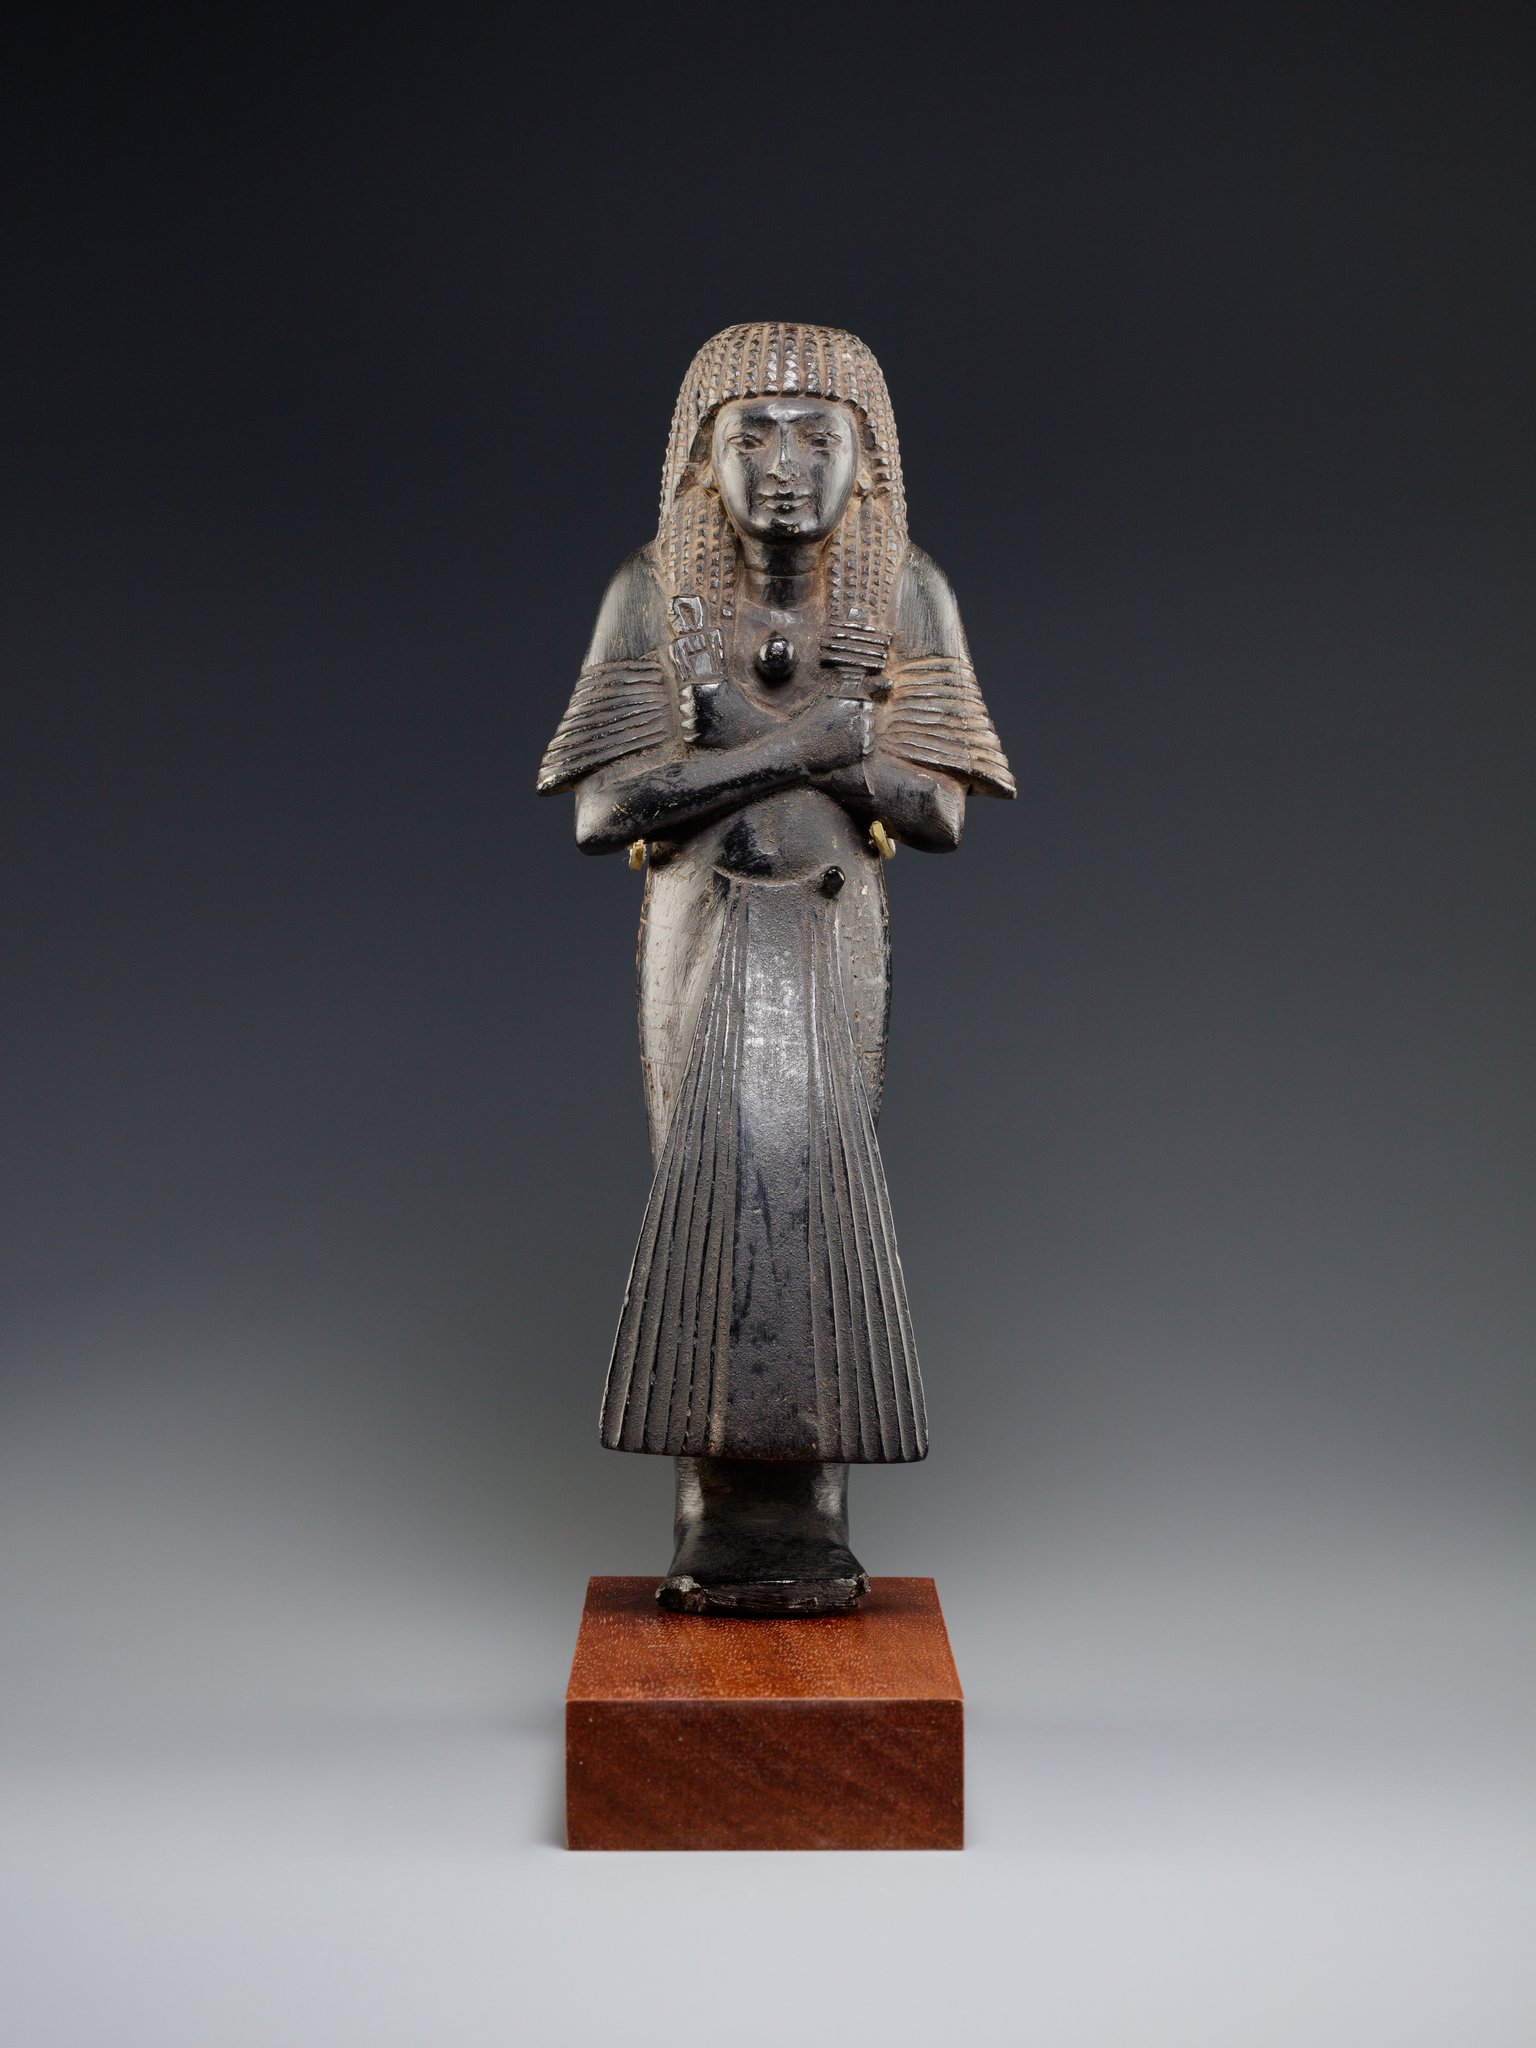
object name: shabti, meryre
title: Shabti of Meryre with a ba-bird on his breast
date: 1353-1336 BCE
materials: stone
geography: middle egypt